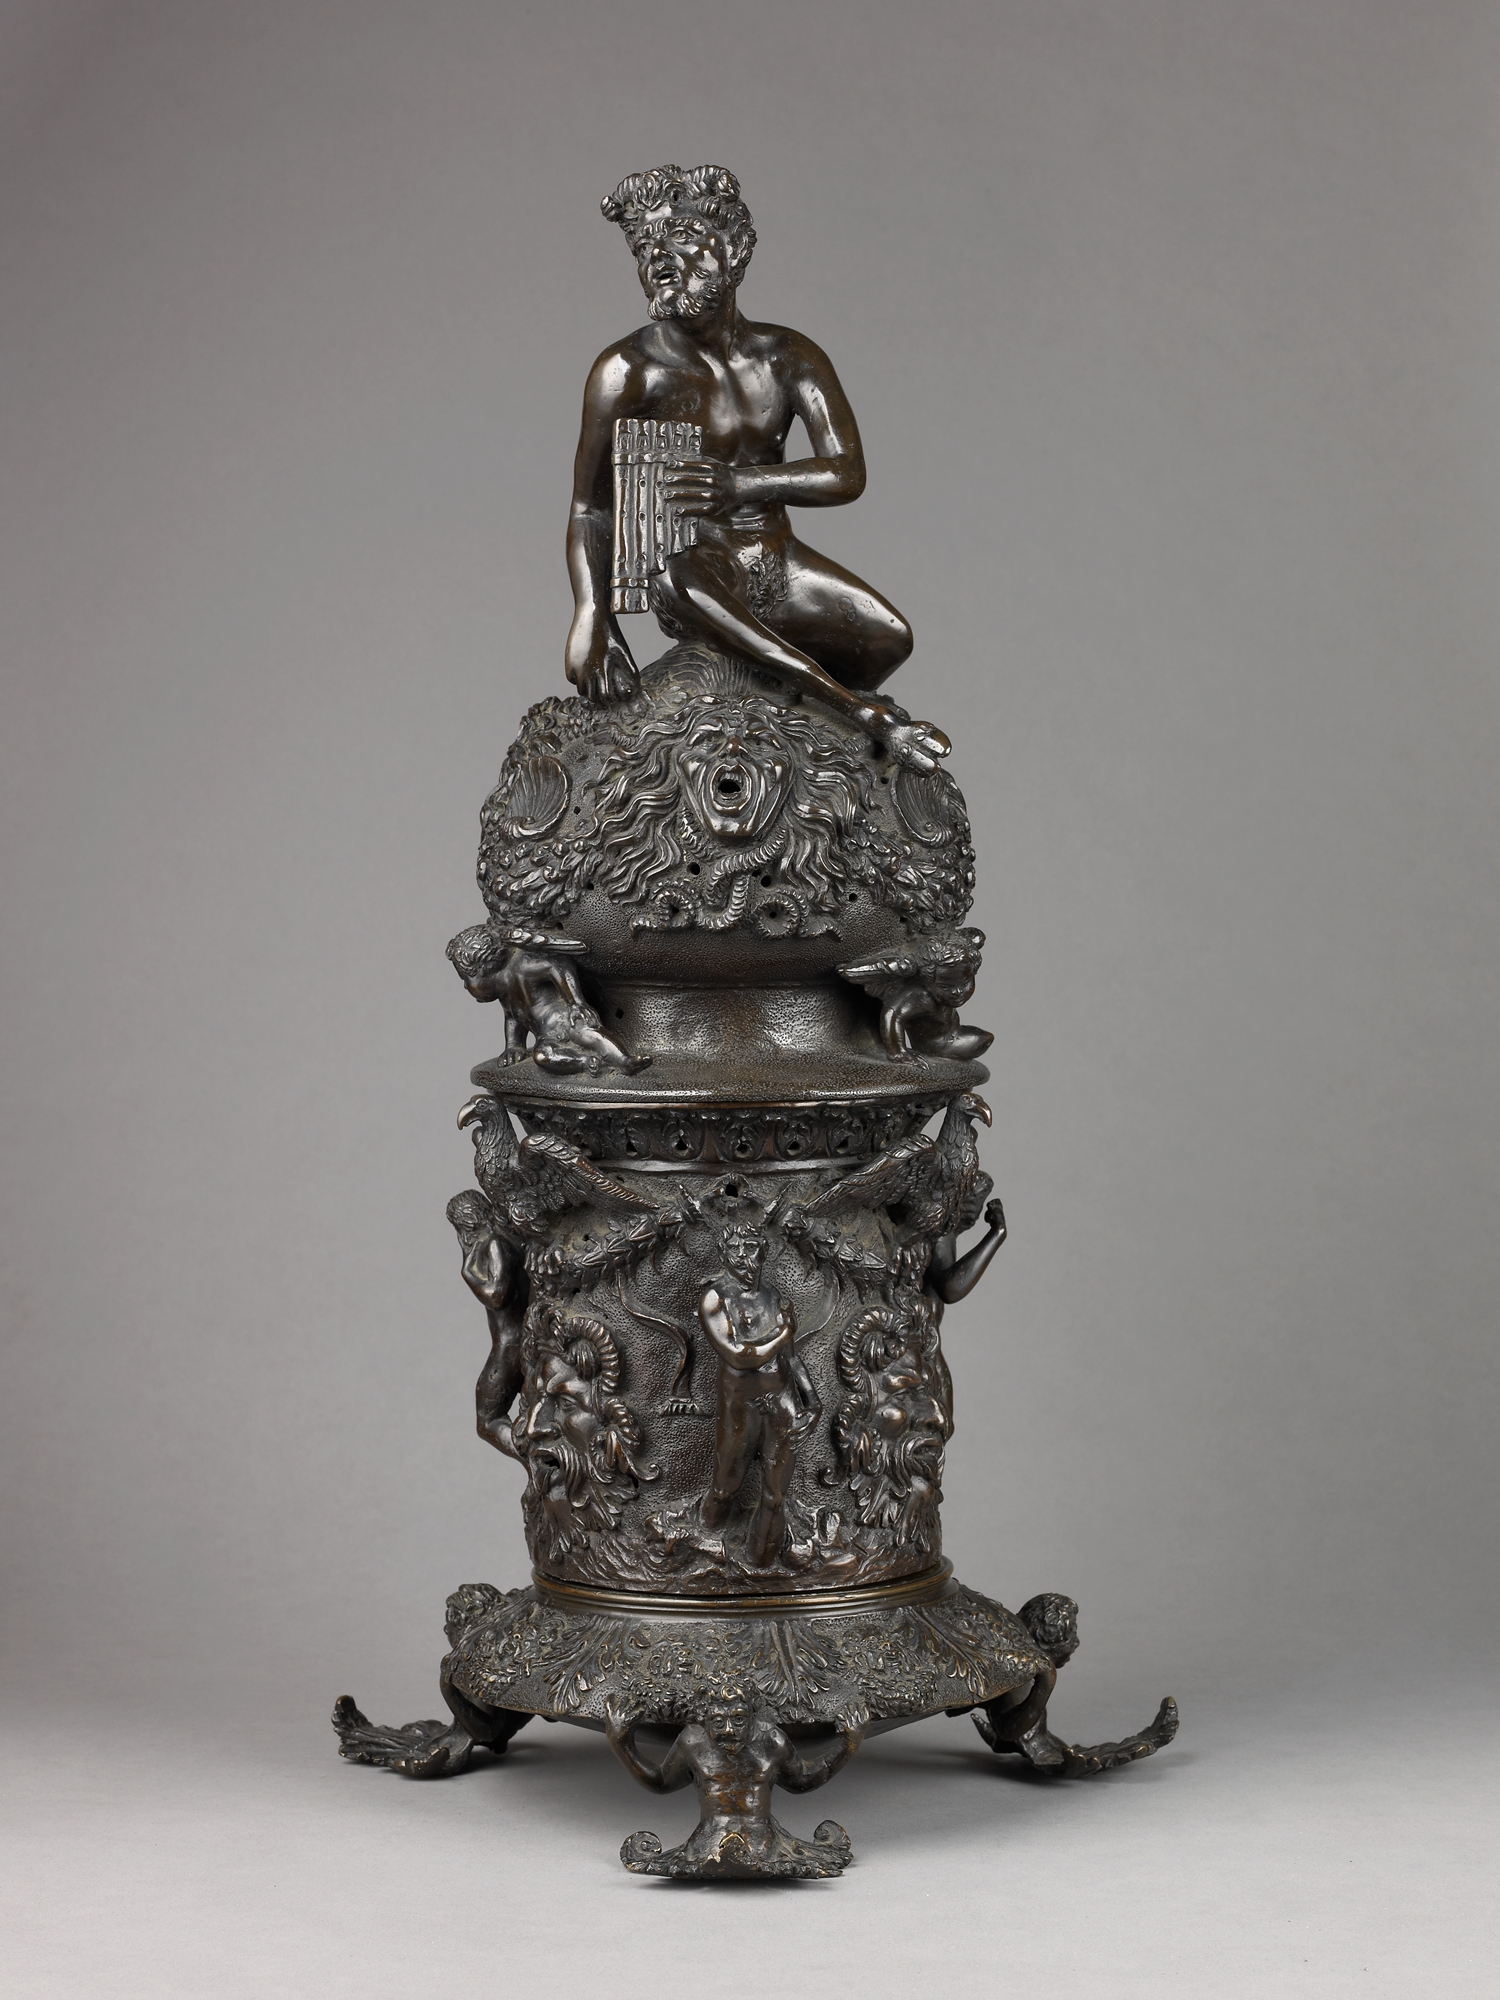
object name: incense burner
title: Perfume Burner Surmounted by a Satyr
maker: desiderio da firenze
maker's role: artist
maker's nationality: italian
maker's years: 1532-1545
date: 1540-1550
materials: brass, bronze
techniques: casting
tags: musical instruments,eagles,satyrs